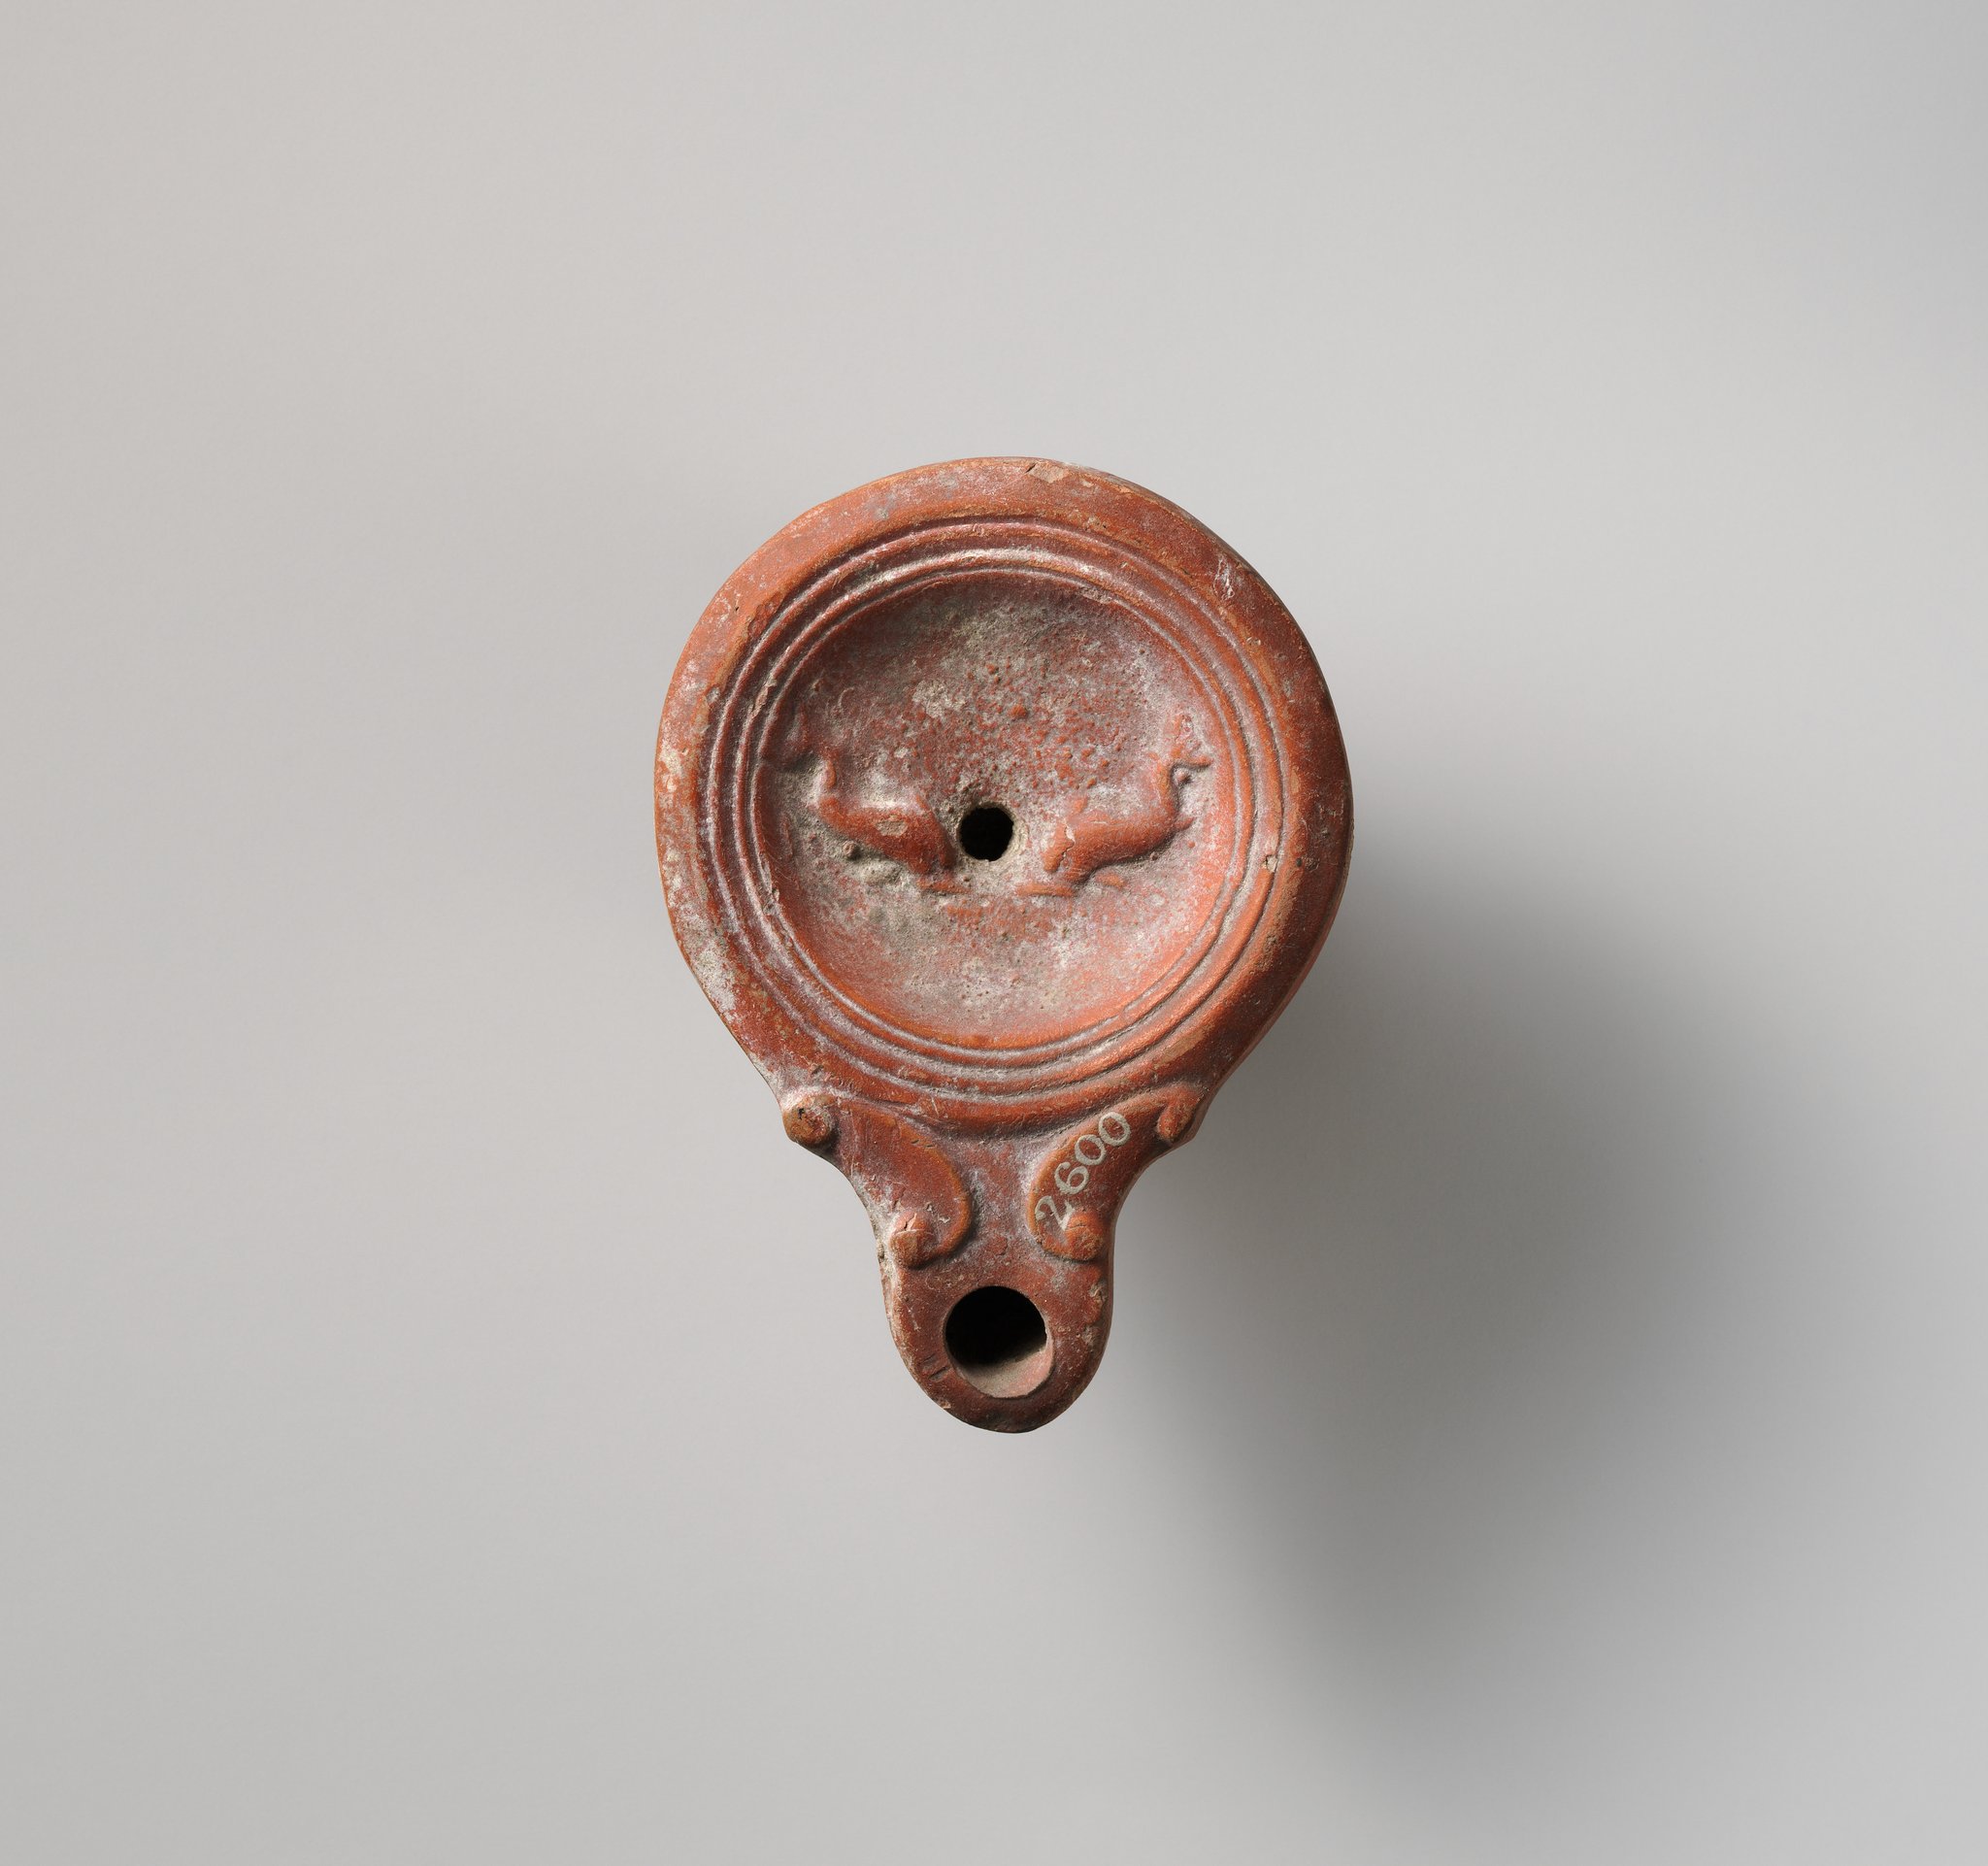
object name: lamp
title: Terracotta oil lamp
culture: roman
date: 100 BCE-100 CE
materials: terracotta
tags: dolphins